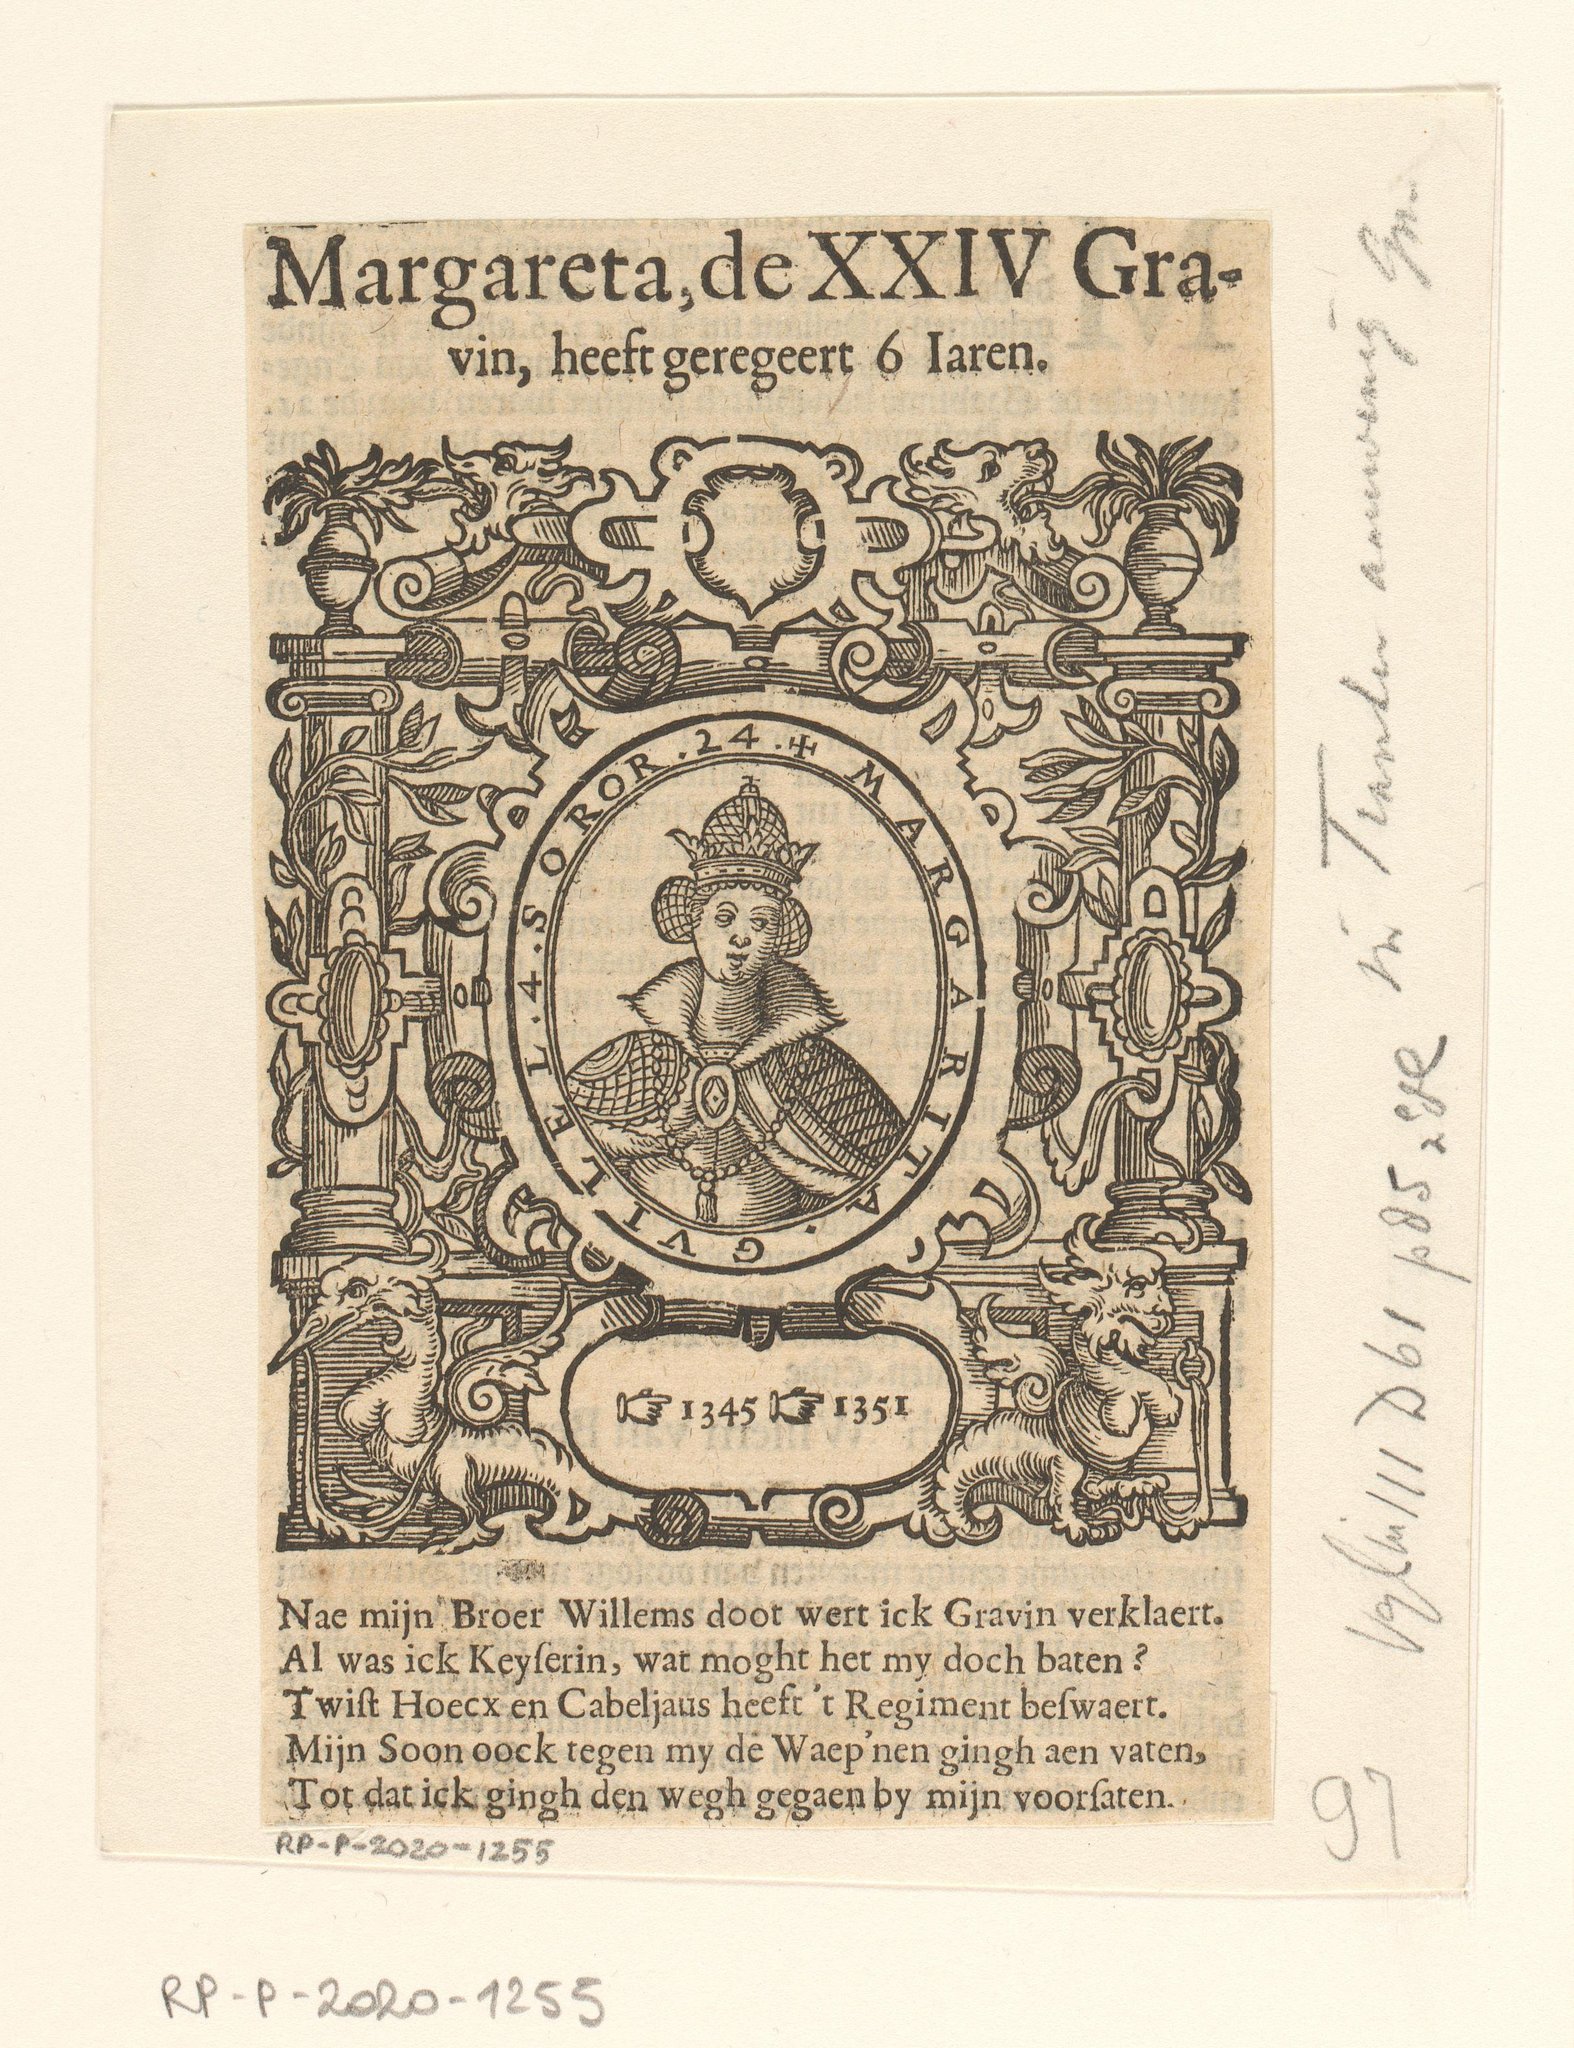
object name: book illustration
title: Margarita guilel 4 soror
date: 1646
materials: paper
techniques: letterpress printing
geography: amsterdam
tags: historical persons, ruler, sovereign - bb - female ruler, nobility and patriciate; chivalry, knighthood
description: Prent uit: Scriverius, Petrus. Beschrivinge van out Batavien met de antiquiteyten vandien (...). Amsterdam: Broer Jansz, 1646, p. 317.